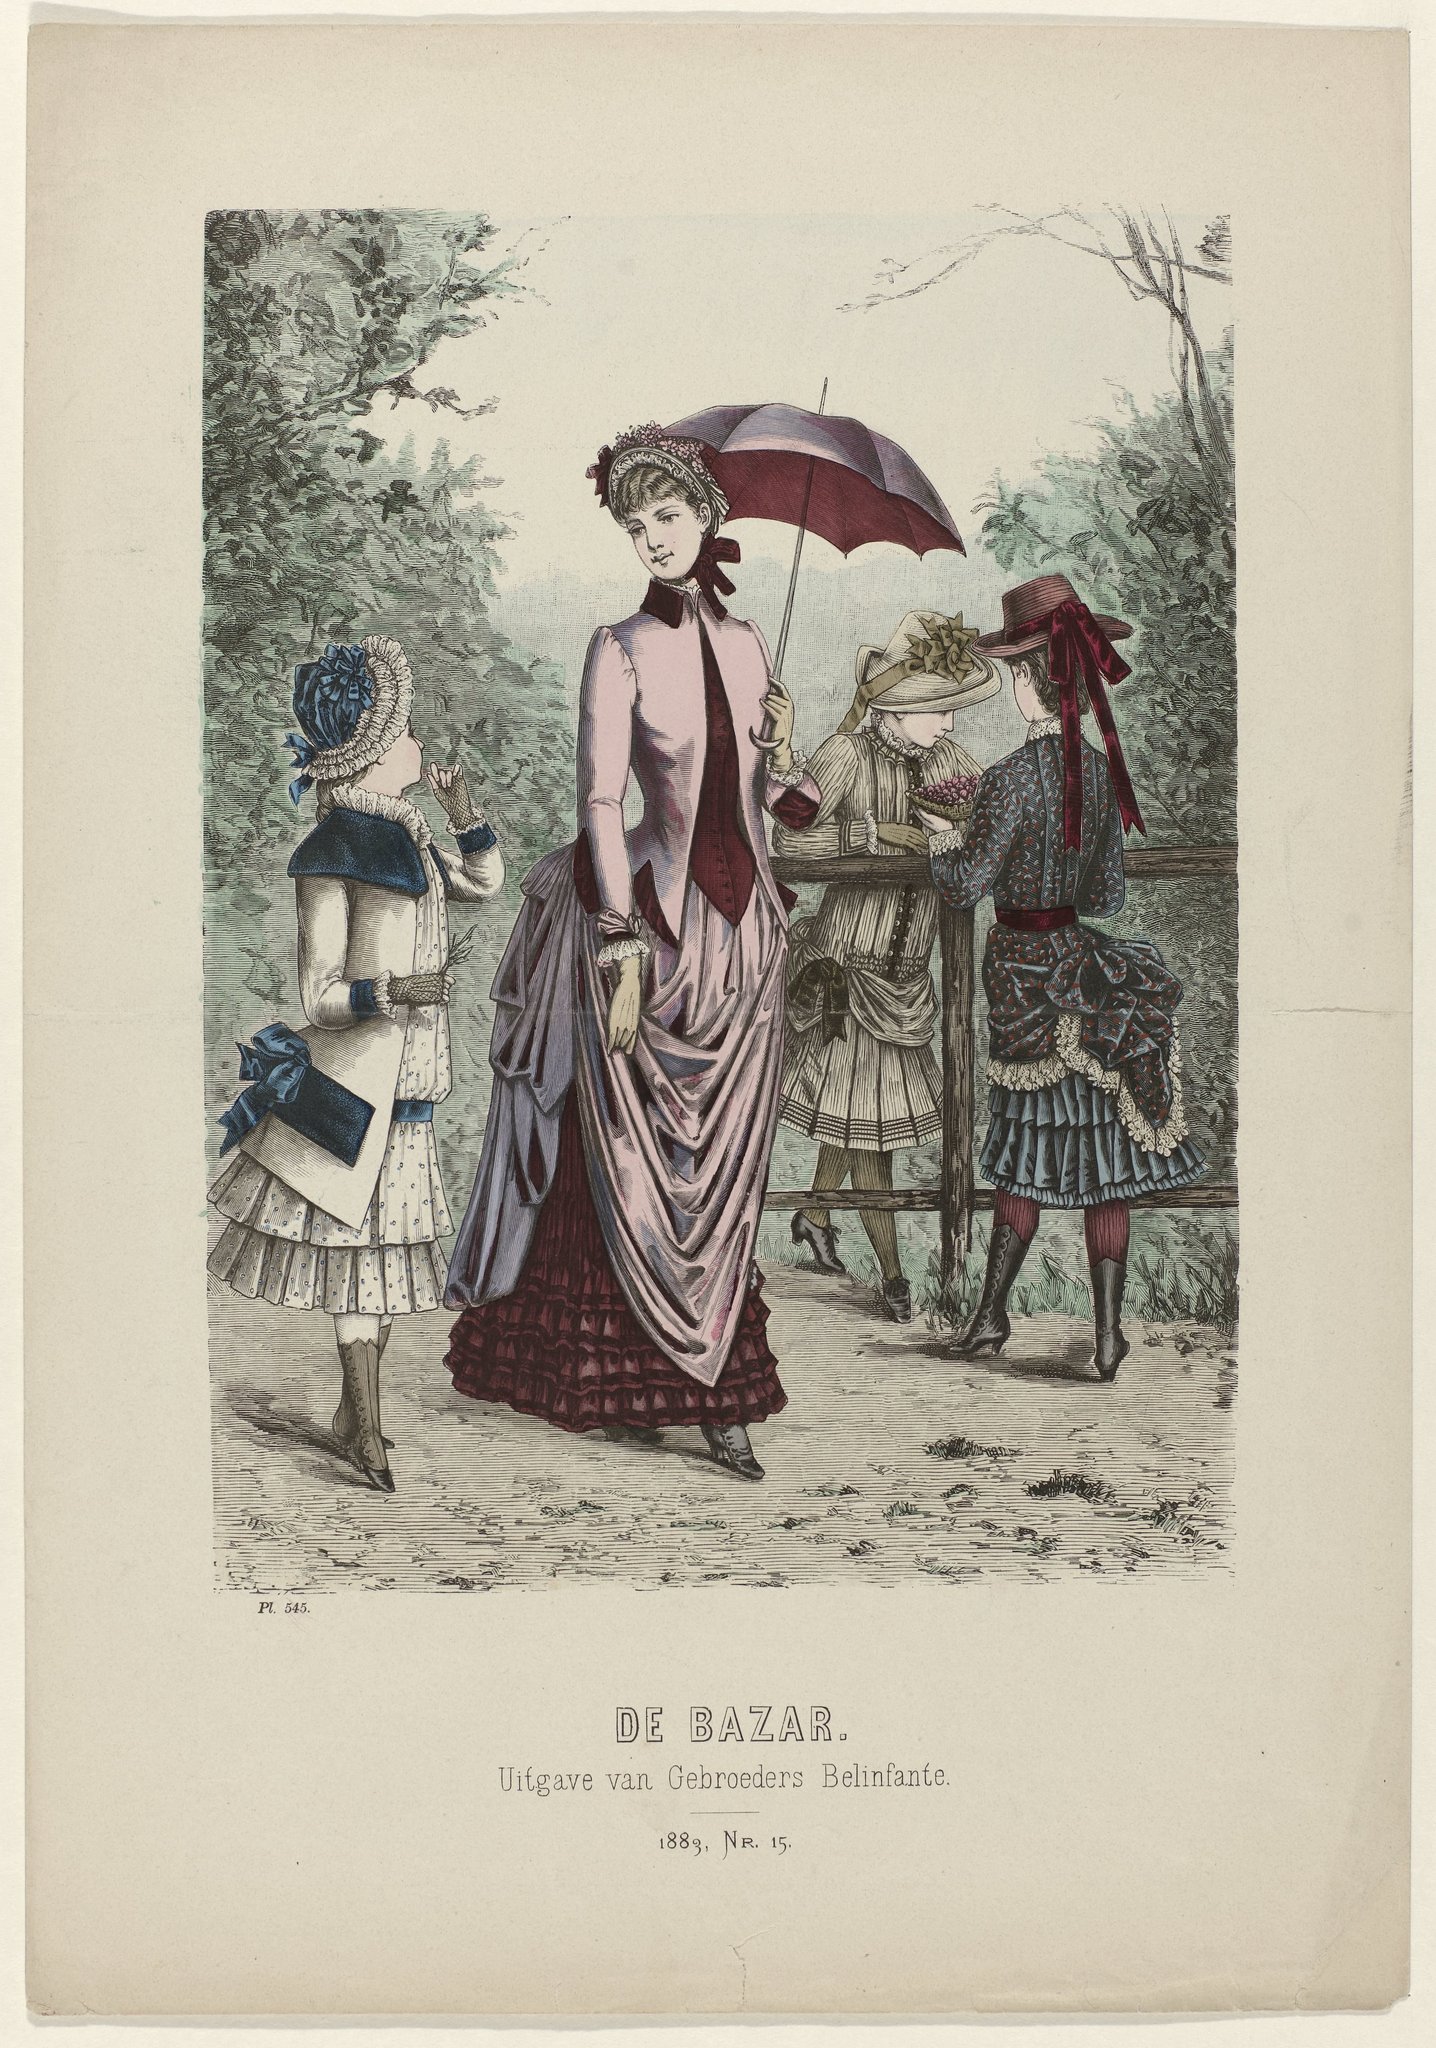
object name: fashion print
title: De Bazar, 1883, Nr. 15, Pl. 545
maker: Anonymous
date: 1883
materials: paper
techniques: hand coloring, engraving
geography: the hague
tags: head-gear: hat (+ girls' clothes), boots (+ girls' clothes), gloves, mittens (mitaines) (+ girls' clothes), fence, wall, paling, fashion plates, head-gear: hat (+ women's clothes), skirt (+ women's clothes), dress, gown (+ women's clothes), parasol, sunshade (+ women's clothes), dress, gown (+ girls' clothes)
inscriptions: caption: ‘DE BAZAR. / Uitgave van Gebroeders Belinfante. / 1883, Nr. 15’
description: Prent uit het modetijdschrift De Bazar, geïllustreerd Tijdschrift voor Modes en Handwerken (1857-1900).